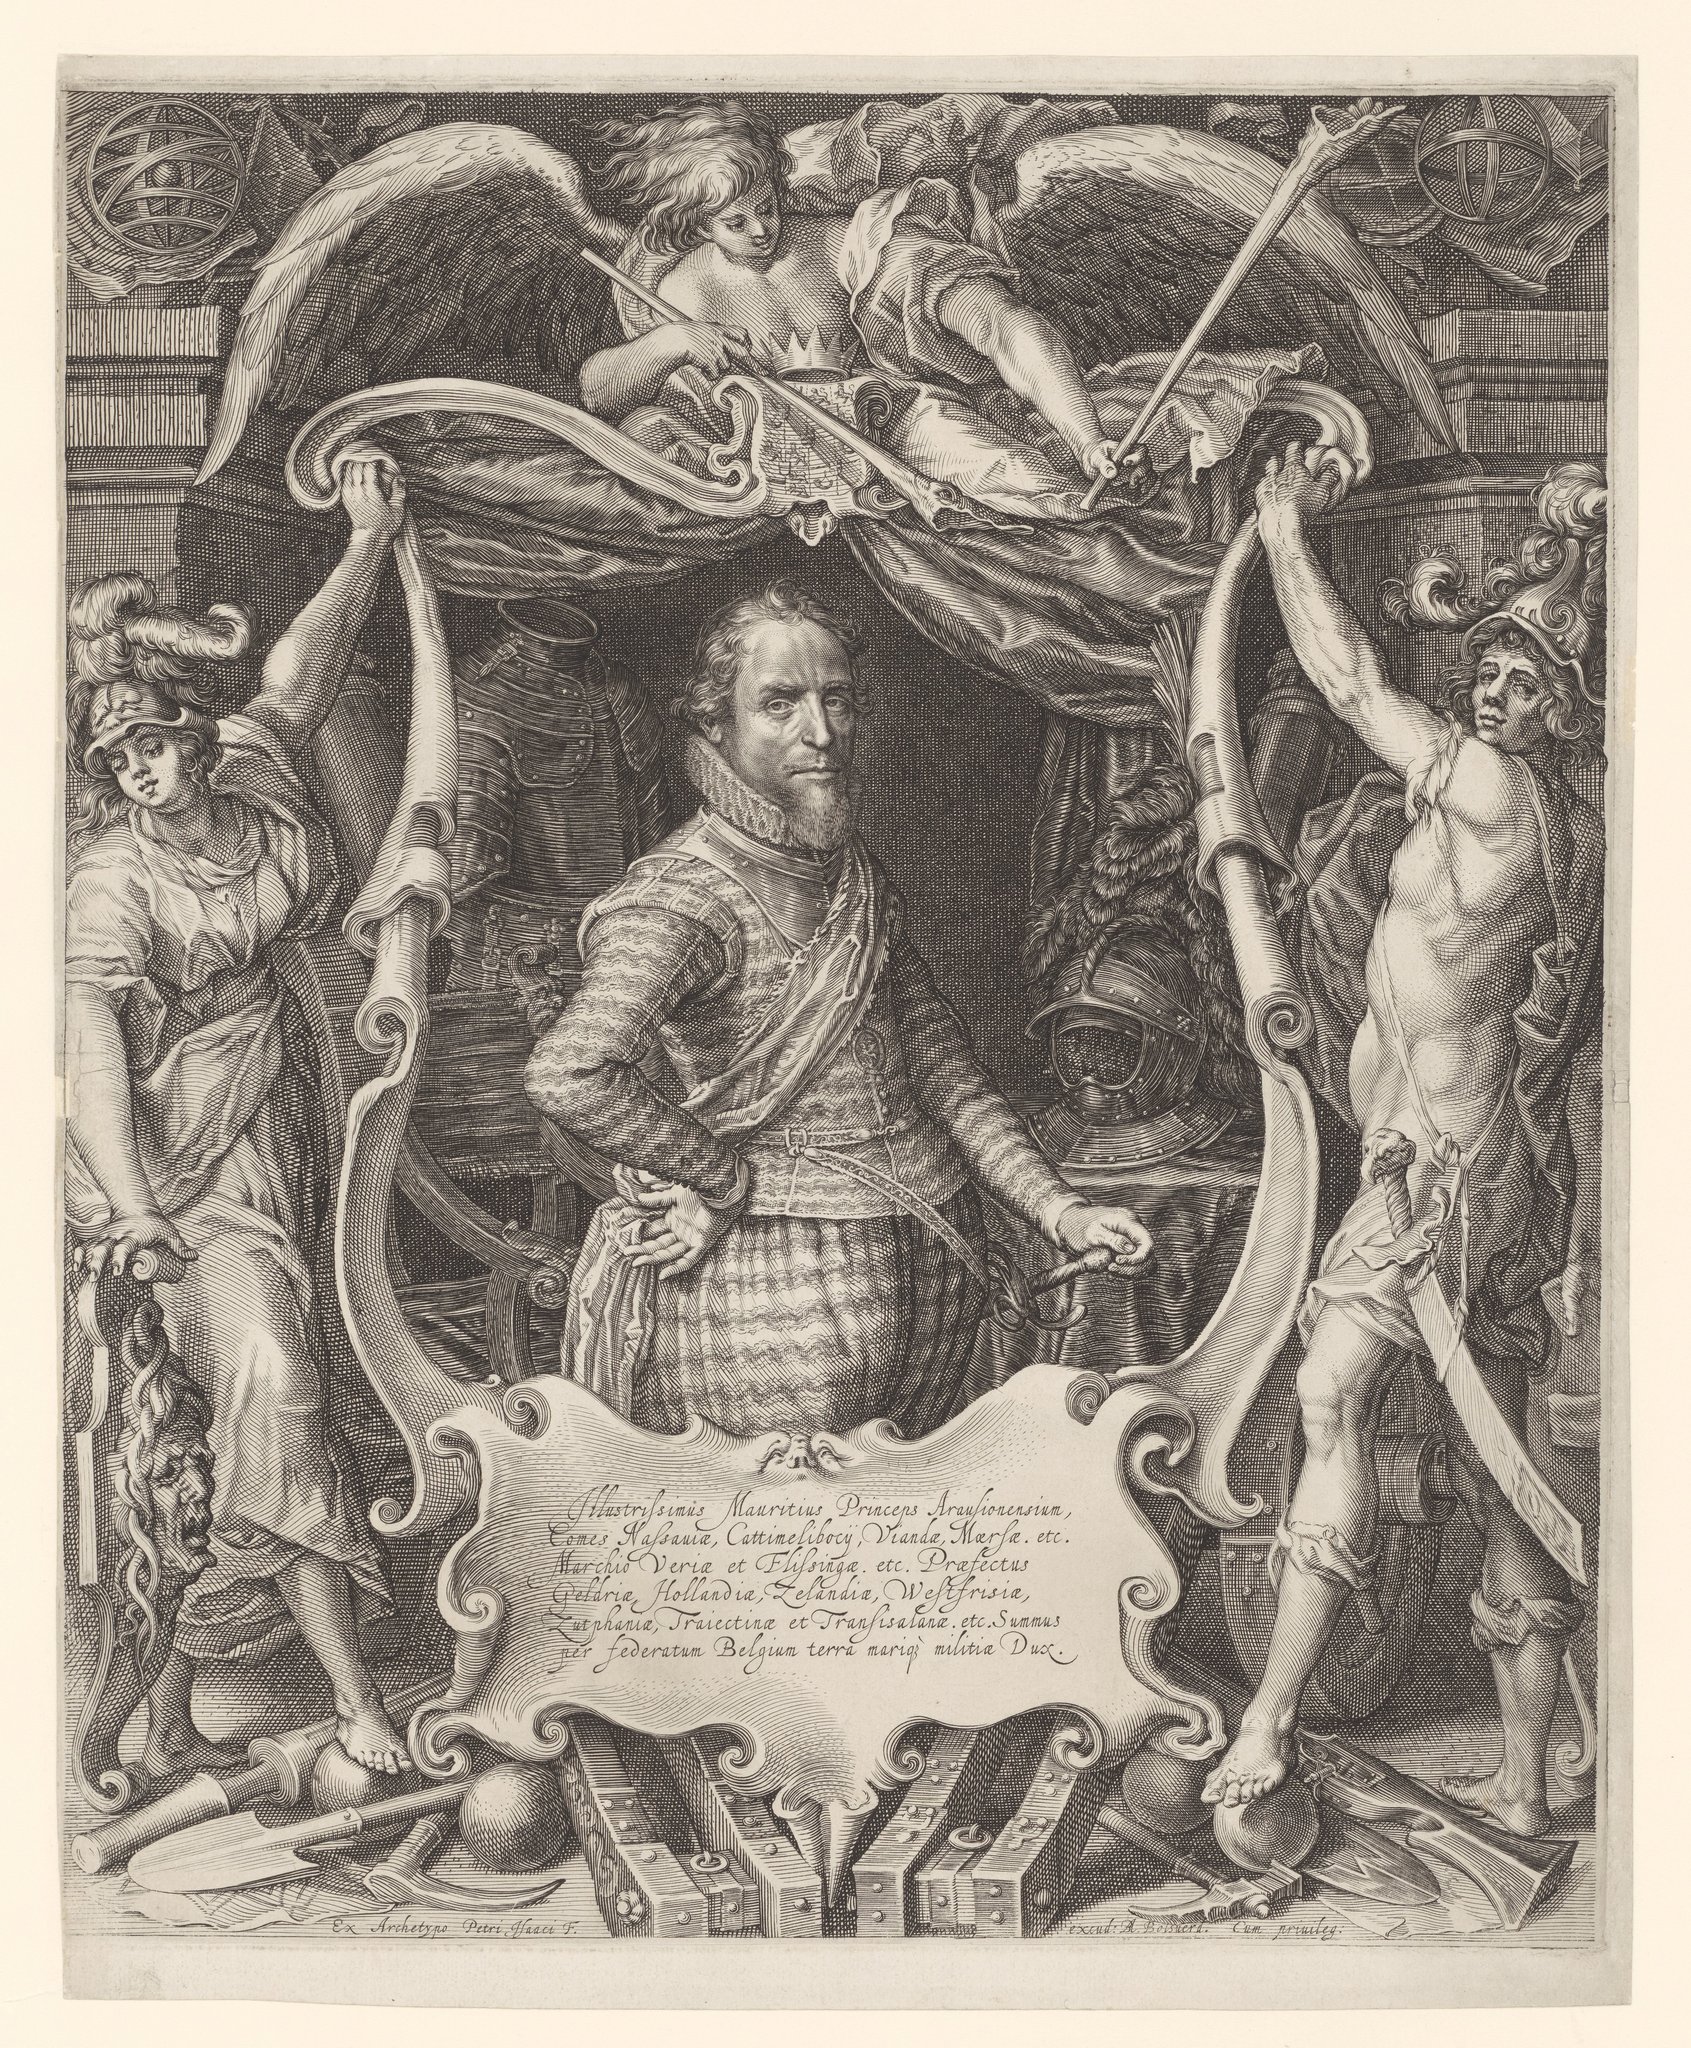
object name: print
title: Portret van Maurits, prins van Oranje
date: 1590-1625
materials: paper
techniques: engraving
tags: the hague, maurice (prince of orange), armour, fama as roman personification, specific aspects, allegorical aspects of minerva; minerva as patroness, warfare; military affairs (+ weapons), specific aspects, allegorical aspects of mars; mars as patron, armorial bearing, heraldry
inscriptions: collector's mark: Lugt 2228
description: Portret van Maurits, prins van Oranje, in allegorische voorstelling. Hij is staande afgebeeld, naar rechts gekeerd, de linkerhand rustend op zijn zwaard. Achter hem zijn wapenrusting: harnas en helm. Hij staat in een cartouche die wordt opgehouden door Mars (rechts) en Minerva (links). Middenboven zijn wapen met kroon, waarboven Fama met twee bazuinen. Onderaan, in cartouche, 6 regels tekst in latijn. Links en rechts van cartouche attributen van de oorlog.